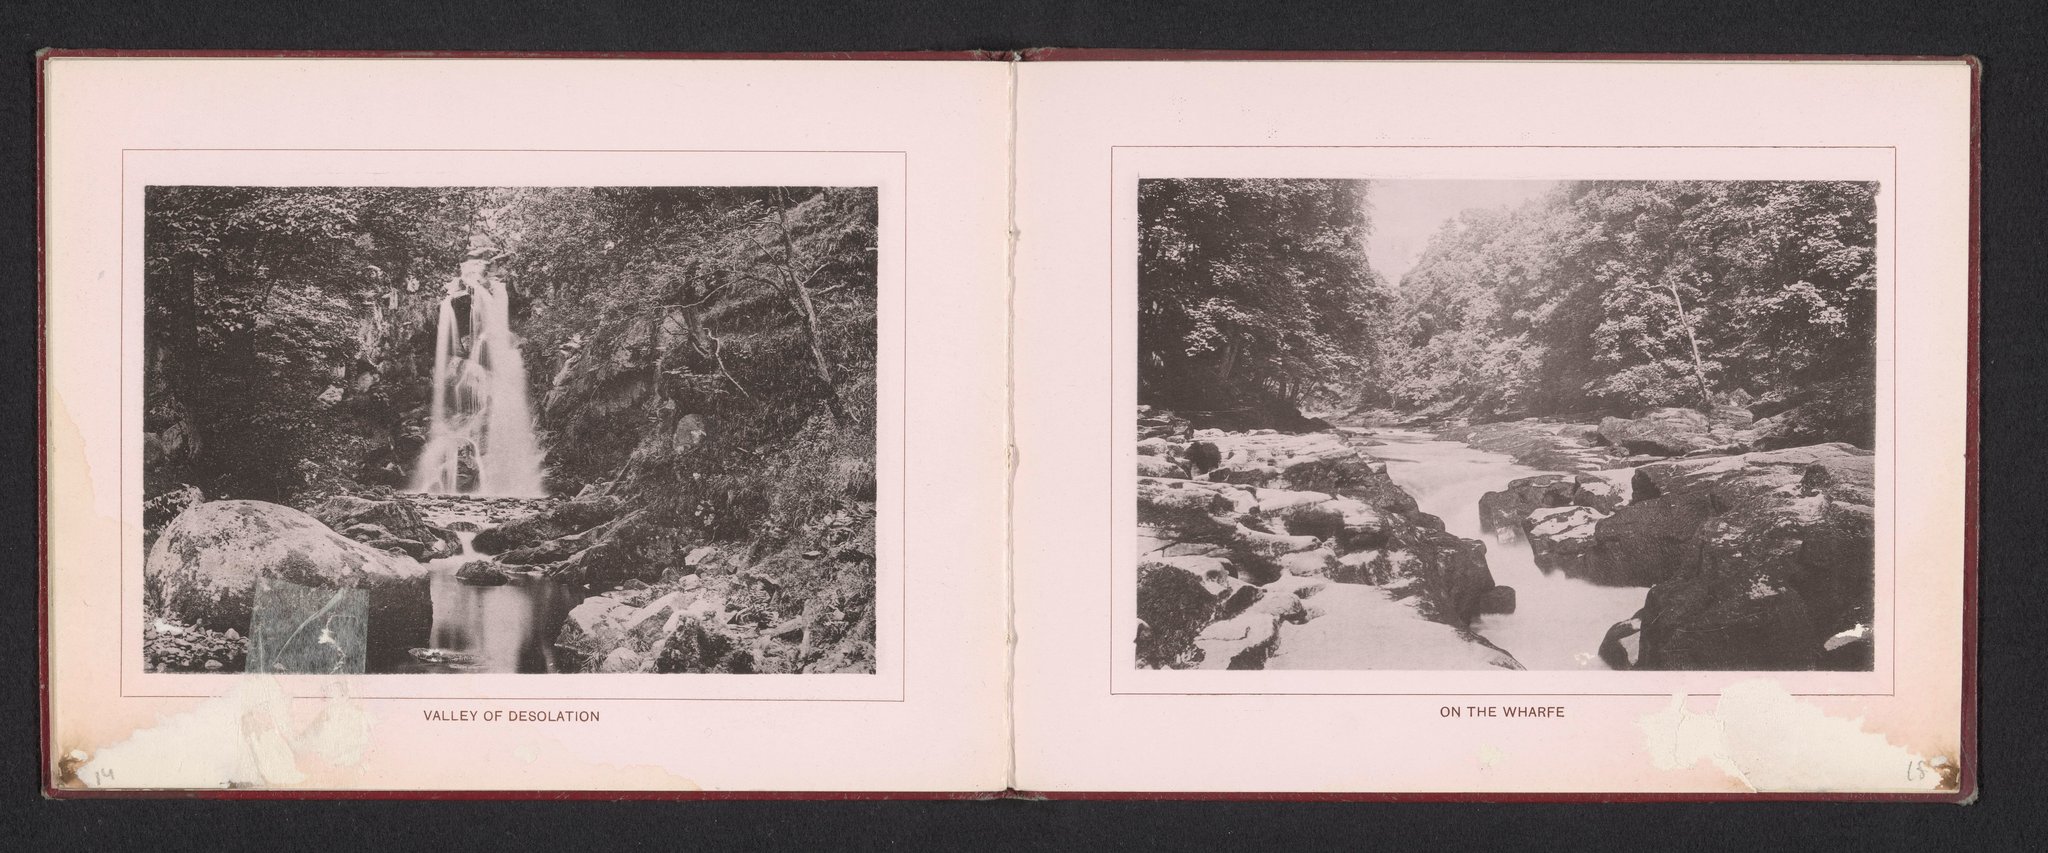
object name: page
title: Valley of desolation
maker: Anonymous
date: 1890-1900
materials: linen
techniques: photograph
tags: waterfall, forest, wood